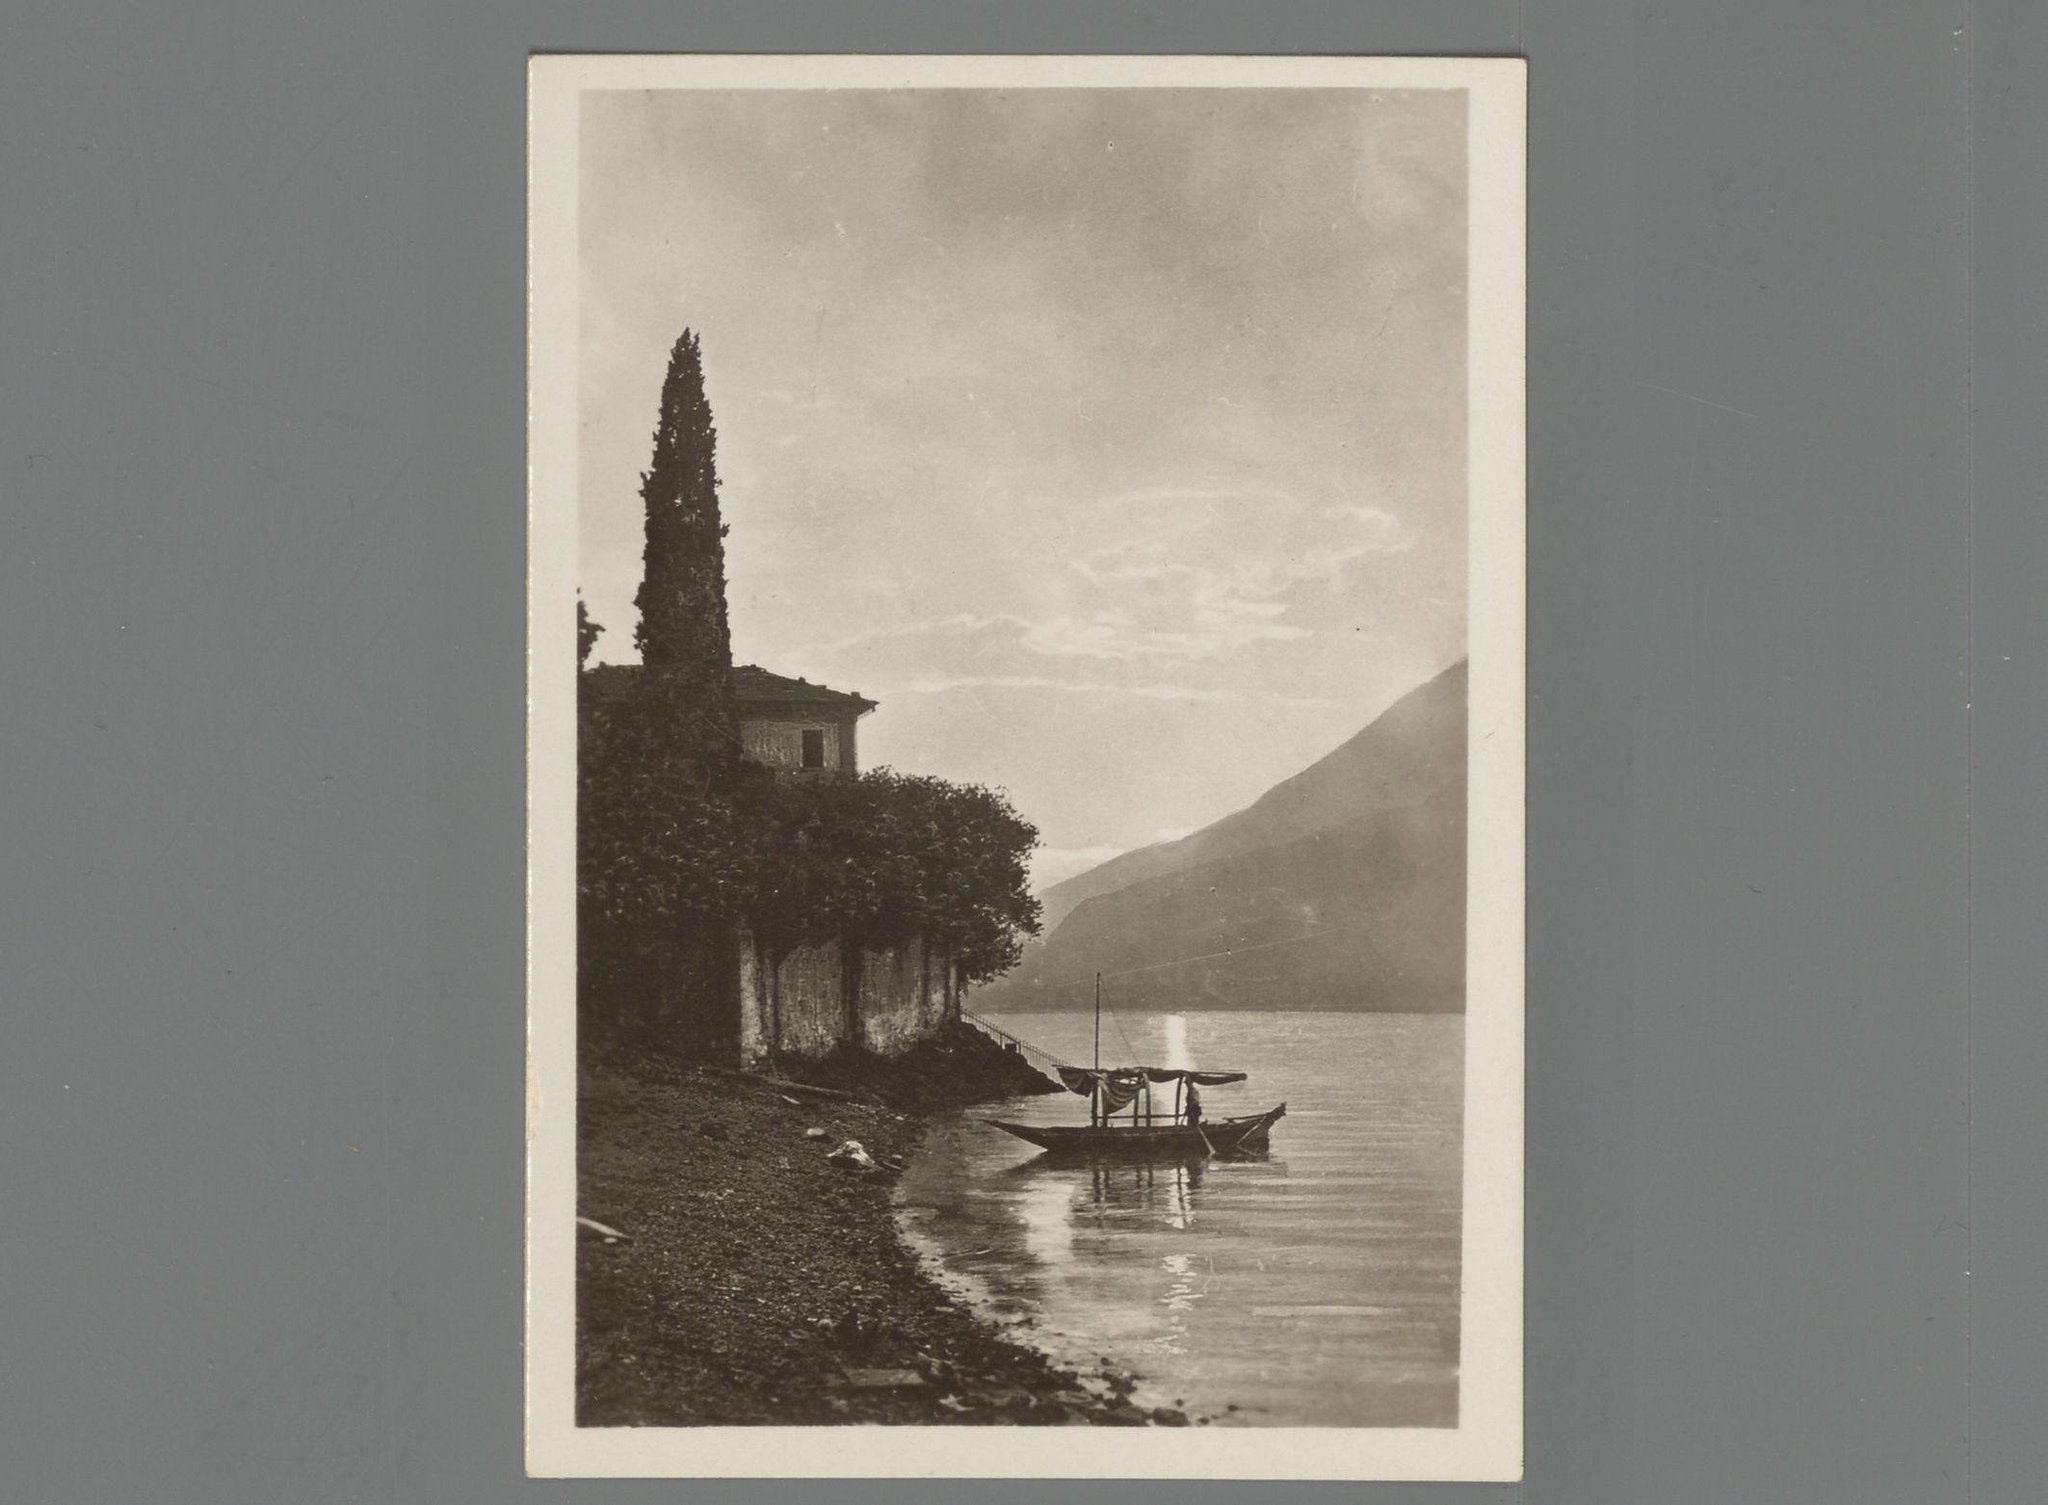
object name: photograph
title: Varenna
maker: Anonymous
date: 1910-1930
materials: paper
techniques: gelatin silver print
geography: varenna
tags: rural housing, e.g. country-house, villa, cottage, lake